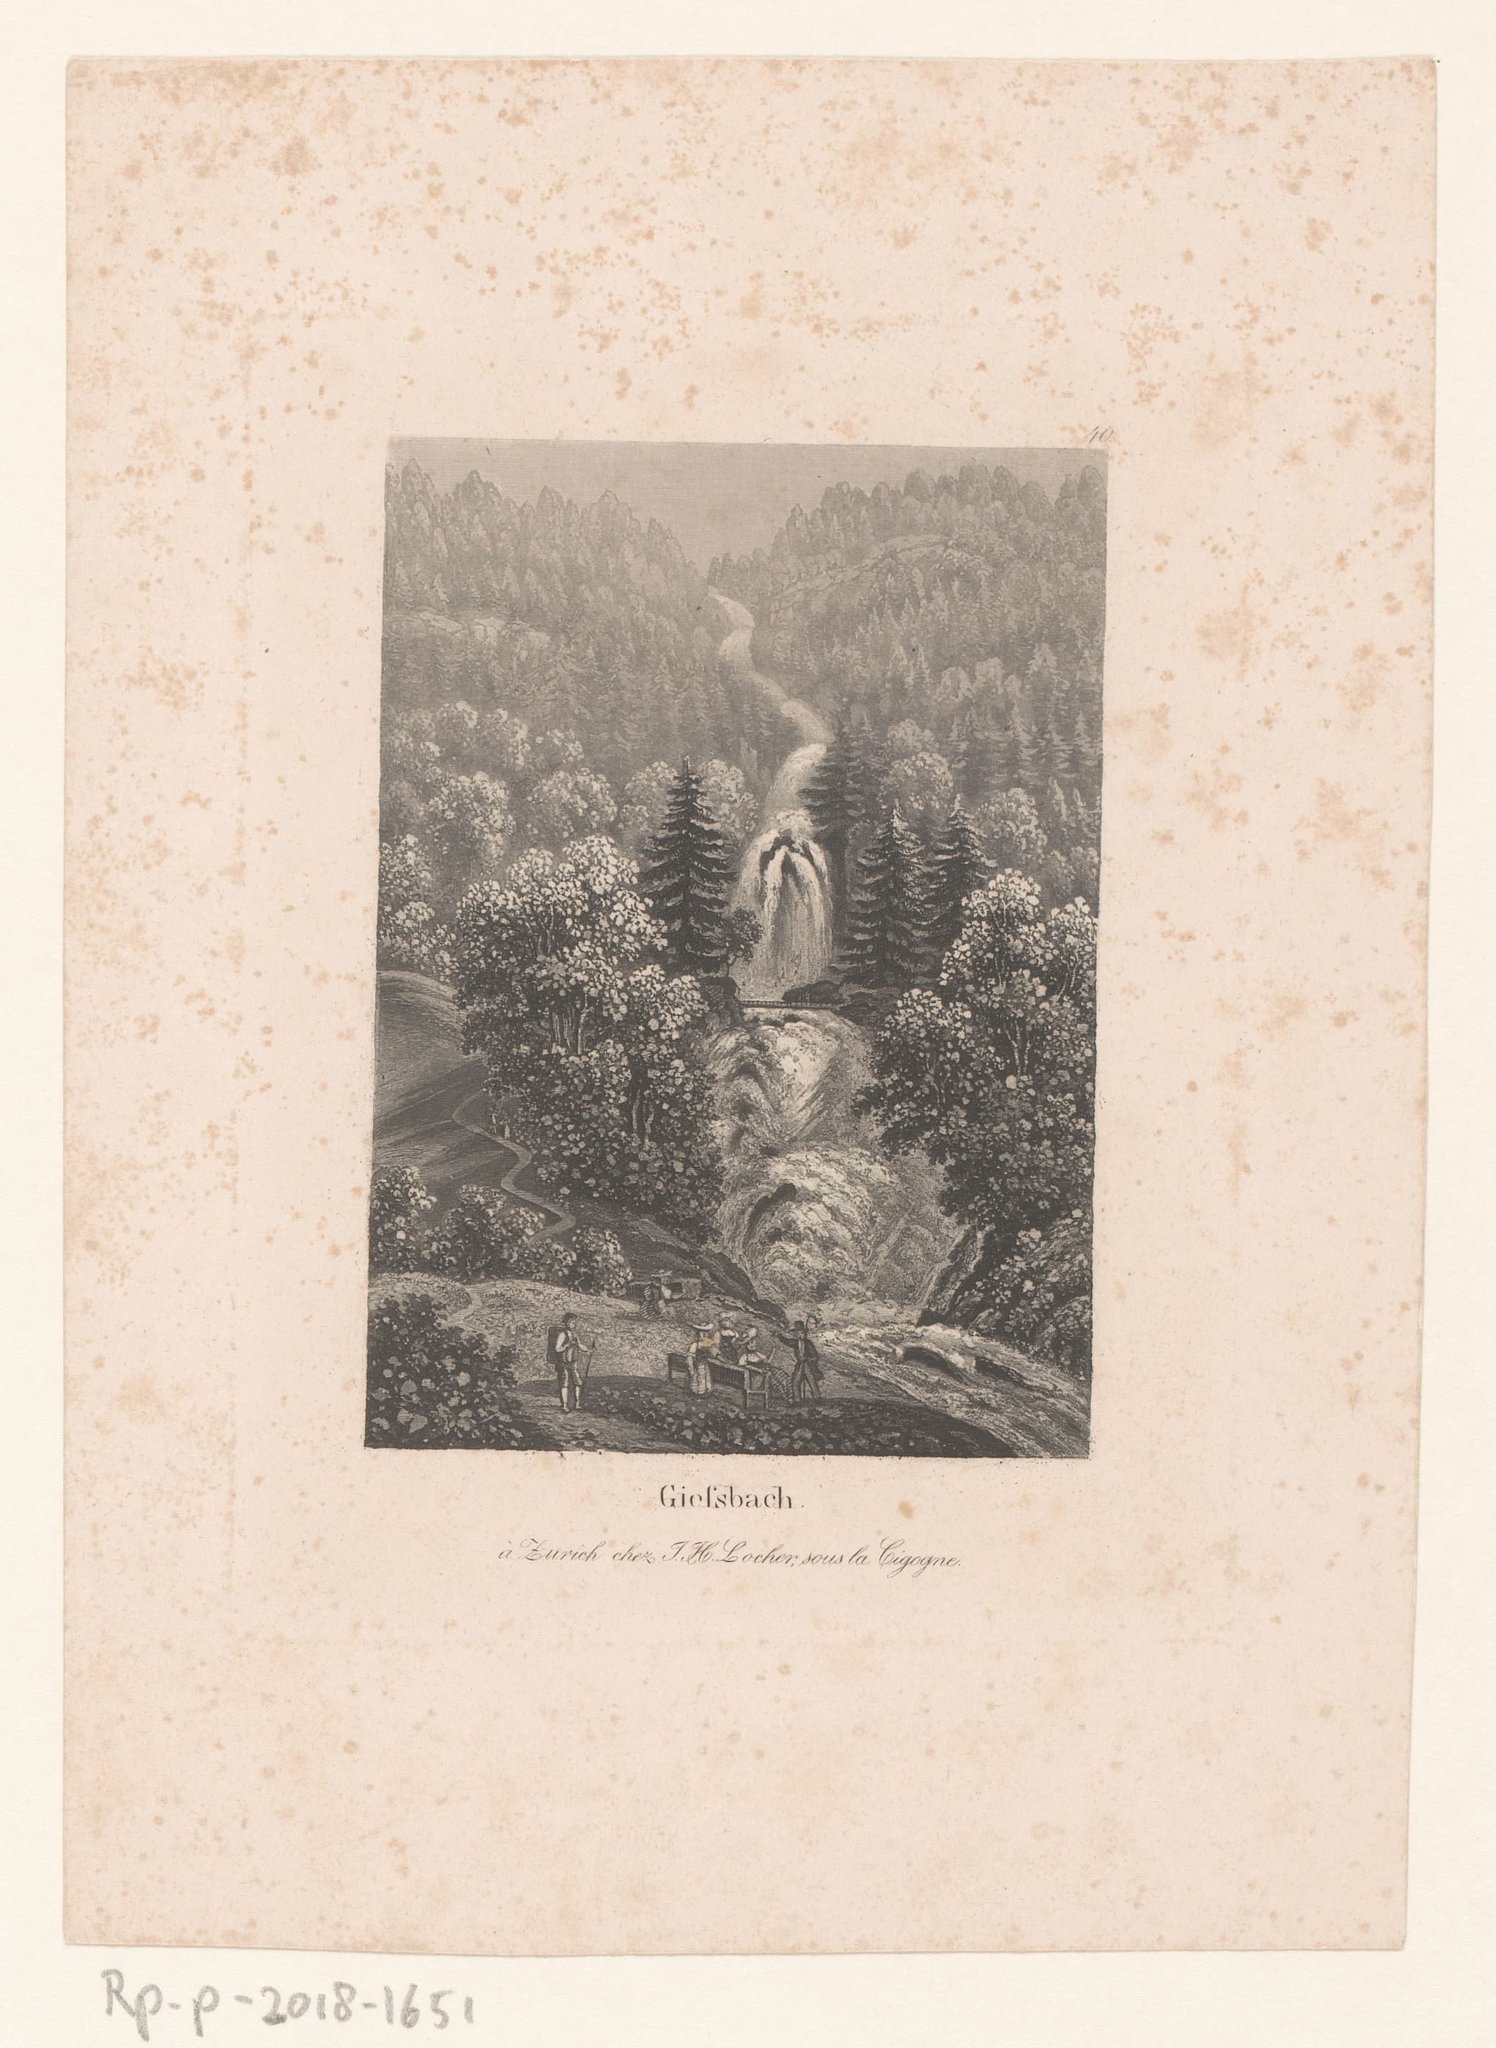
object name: print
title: Giessbach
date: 1820-1892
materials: paper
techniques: aquatint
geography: zurich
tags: waterfall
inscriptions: collector's mark: Lugt 2228